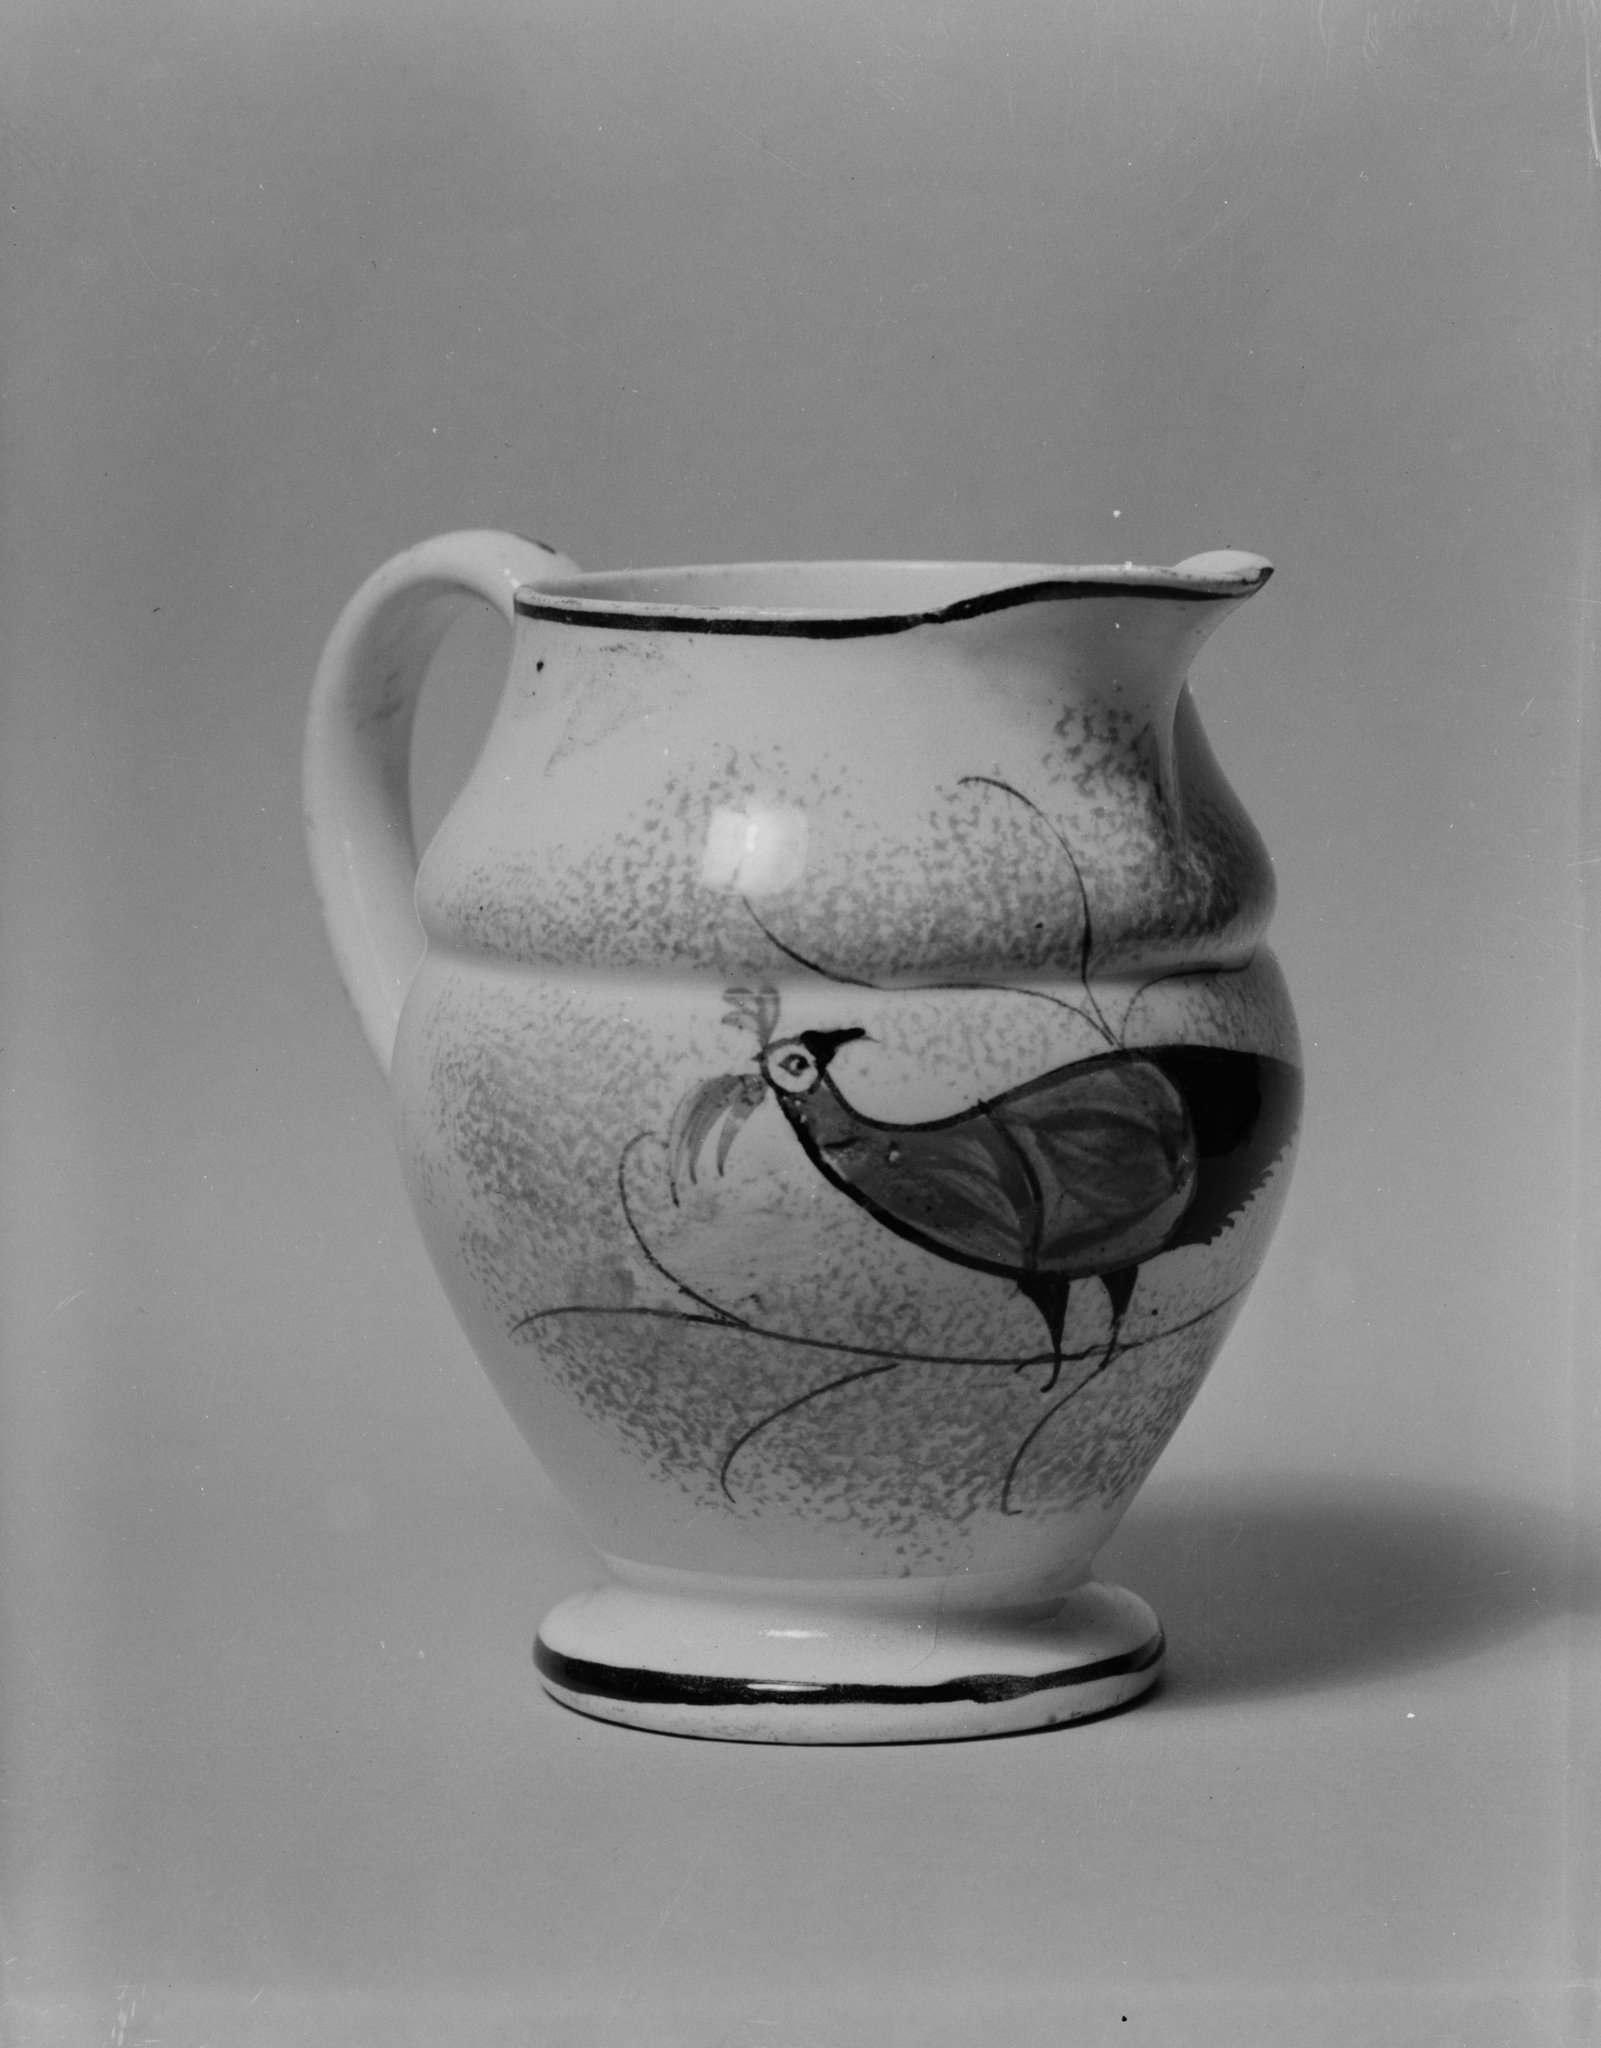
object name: pitcher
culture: british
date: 1800-1830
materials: earthenware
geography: england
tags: birds